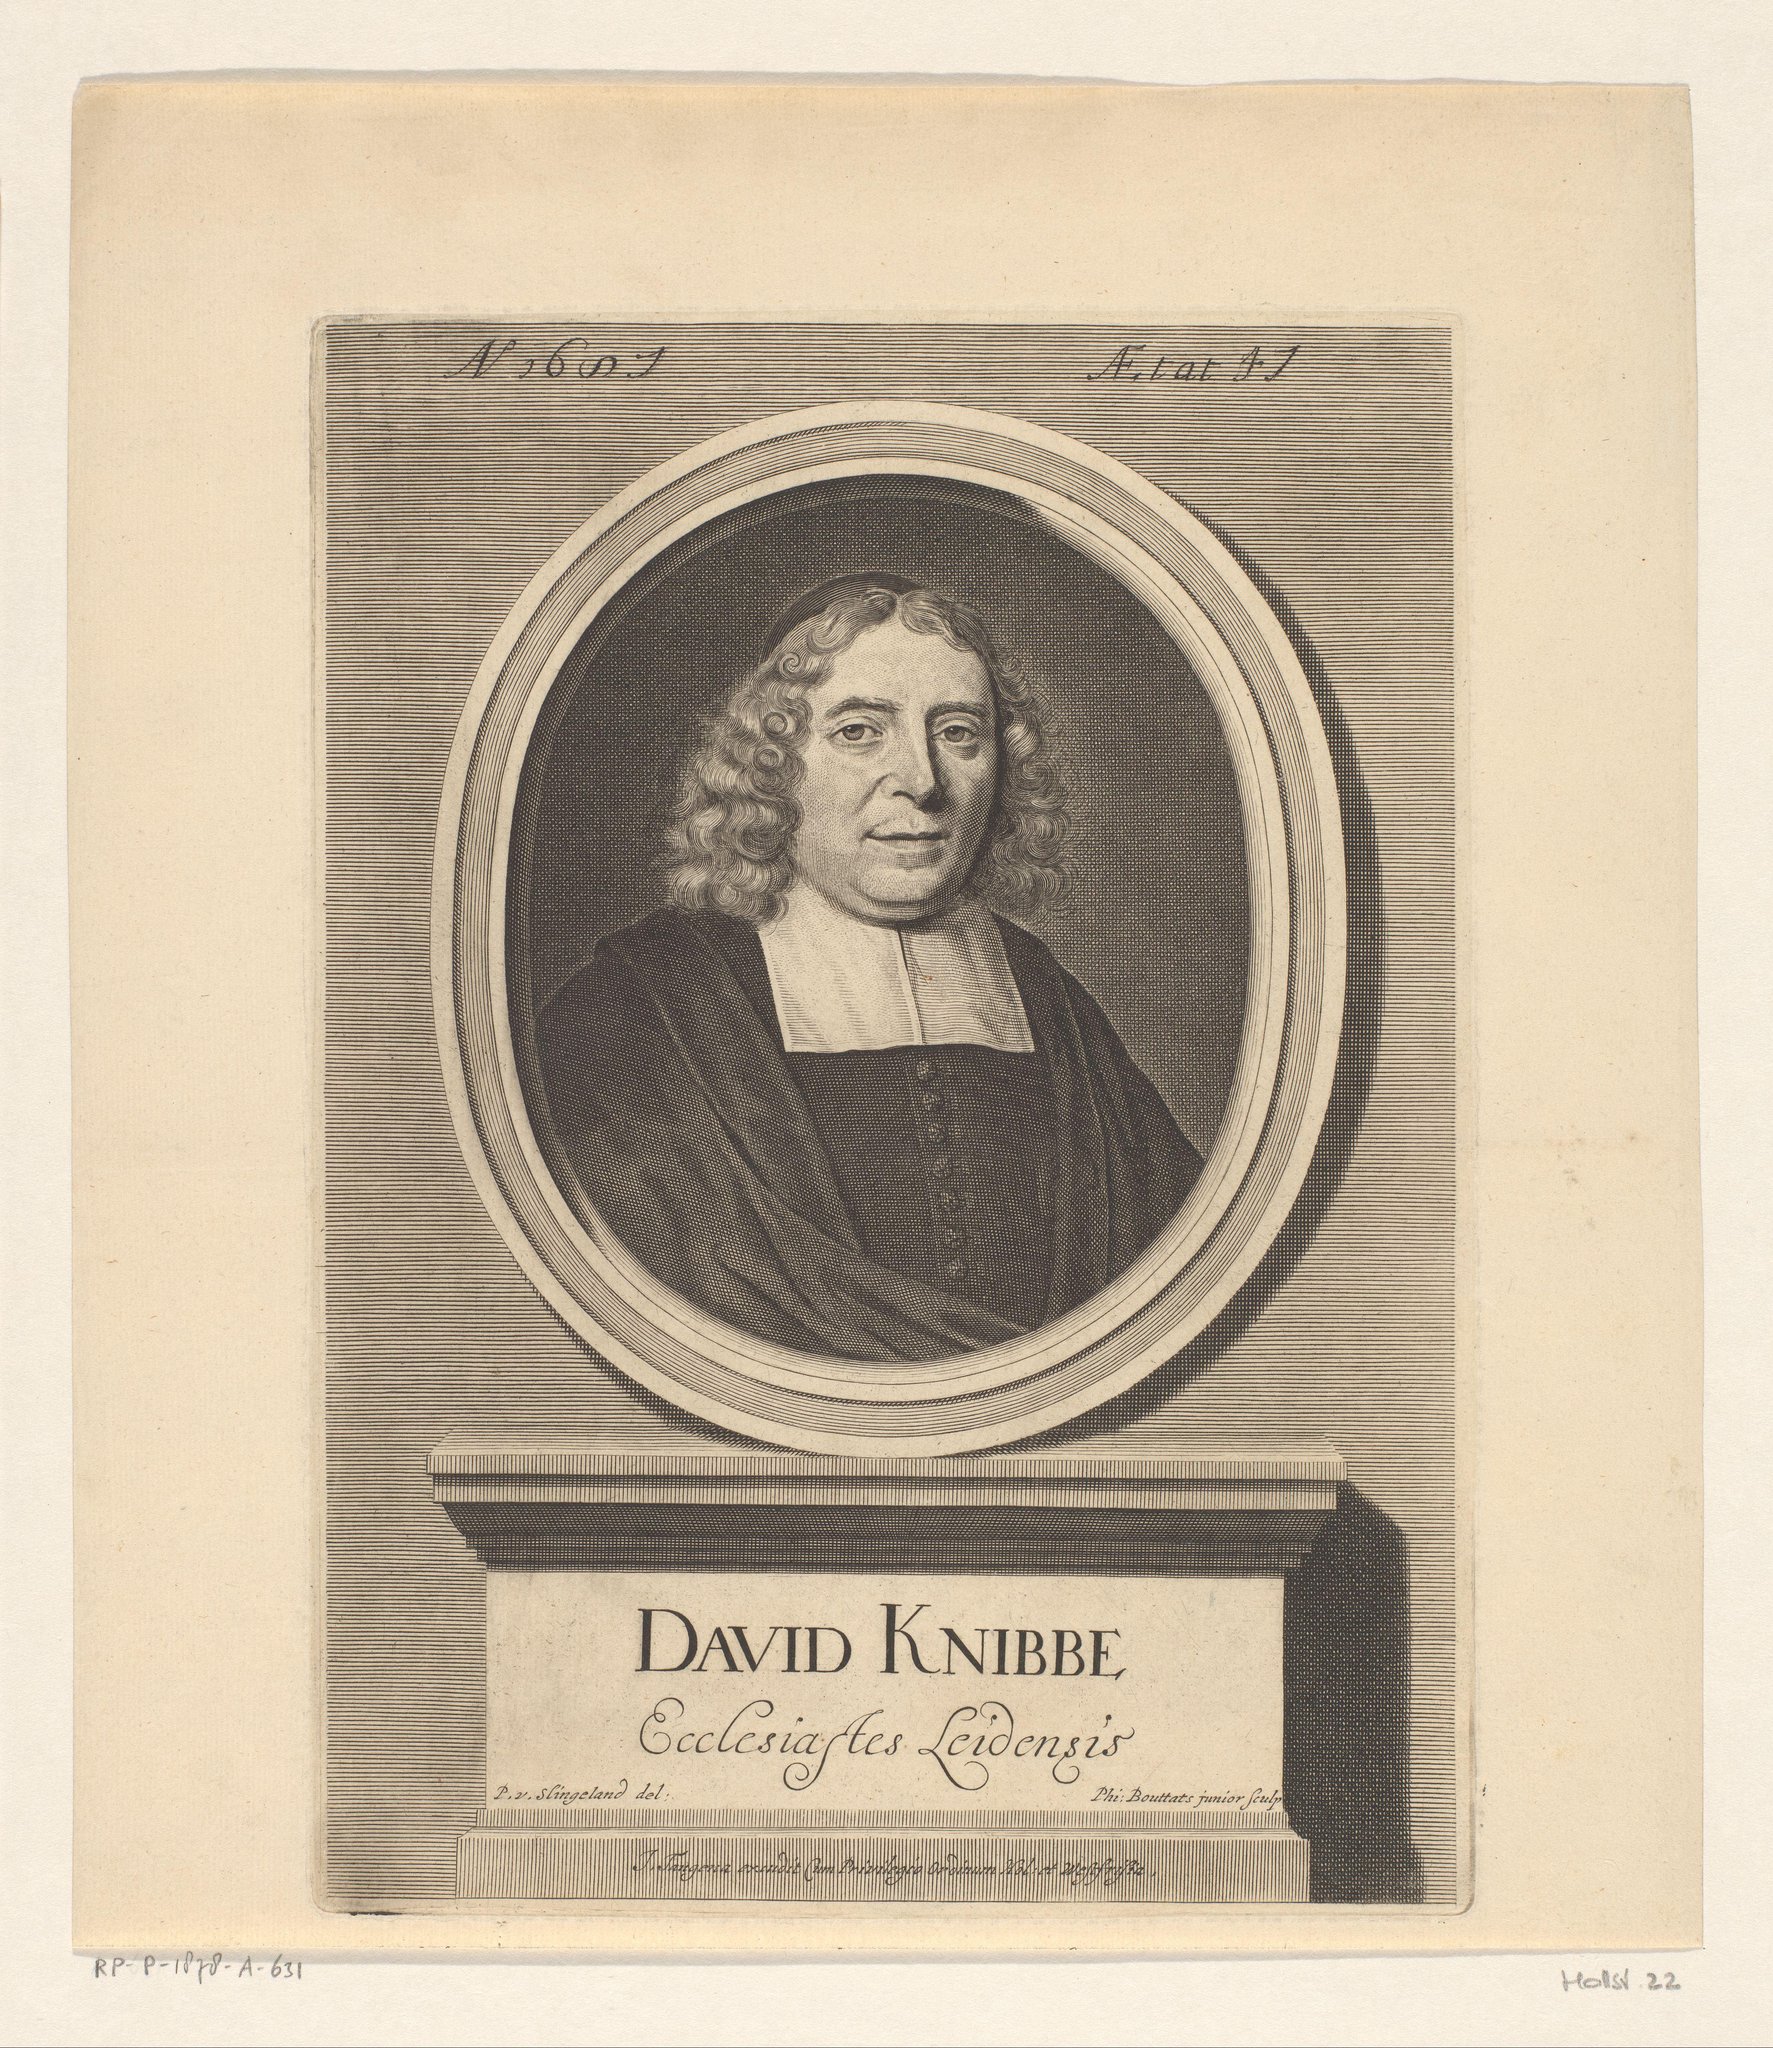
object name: print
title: Portret van David Knibbe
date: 1685-1736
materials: paper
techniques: engraving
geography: netherlands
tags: predikant, david knibbe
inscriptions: collector's mark: Lugt 2228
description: Portret in ovale lijst van David Knibbe, dominee te leiden. Buste naar rechts. Knibbe draagt een toga en witte bef.